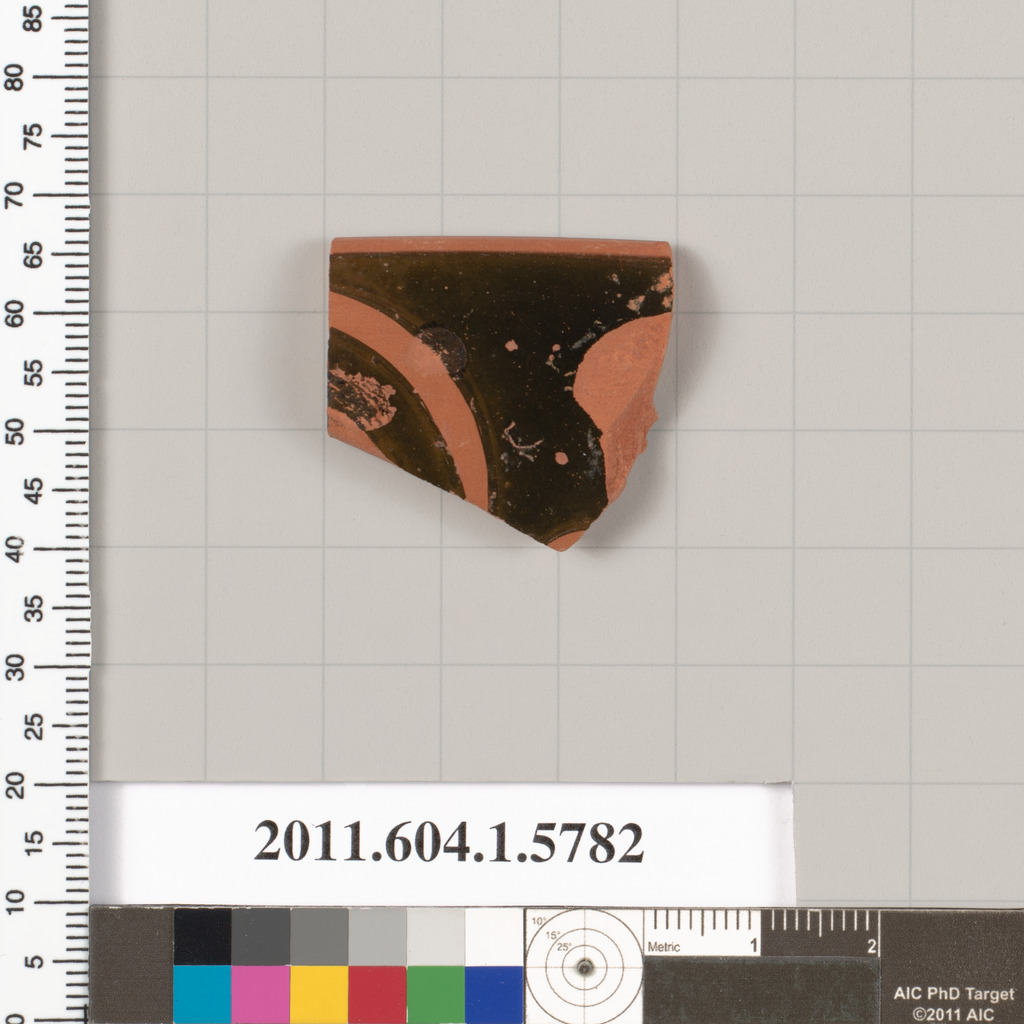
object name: kylix fragment, eye cup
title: Terracotta rim fragment of a kylix: eye-cup (drinking cup)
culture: greek, attic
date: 525-510 BCE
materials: terracotta